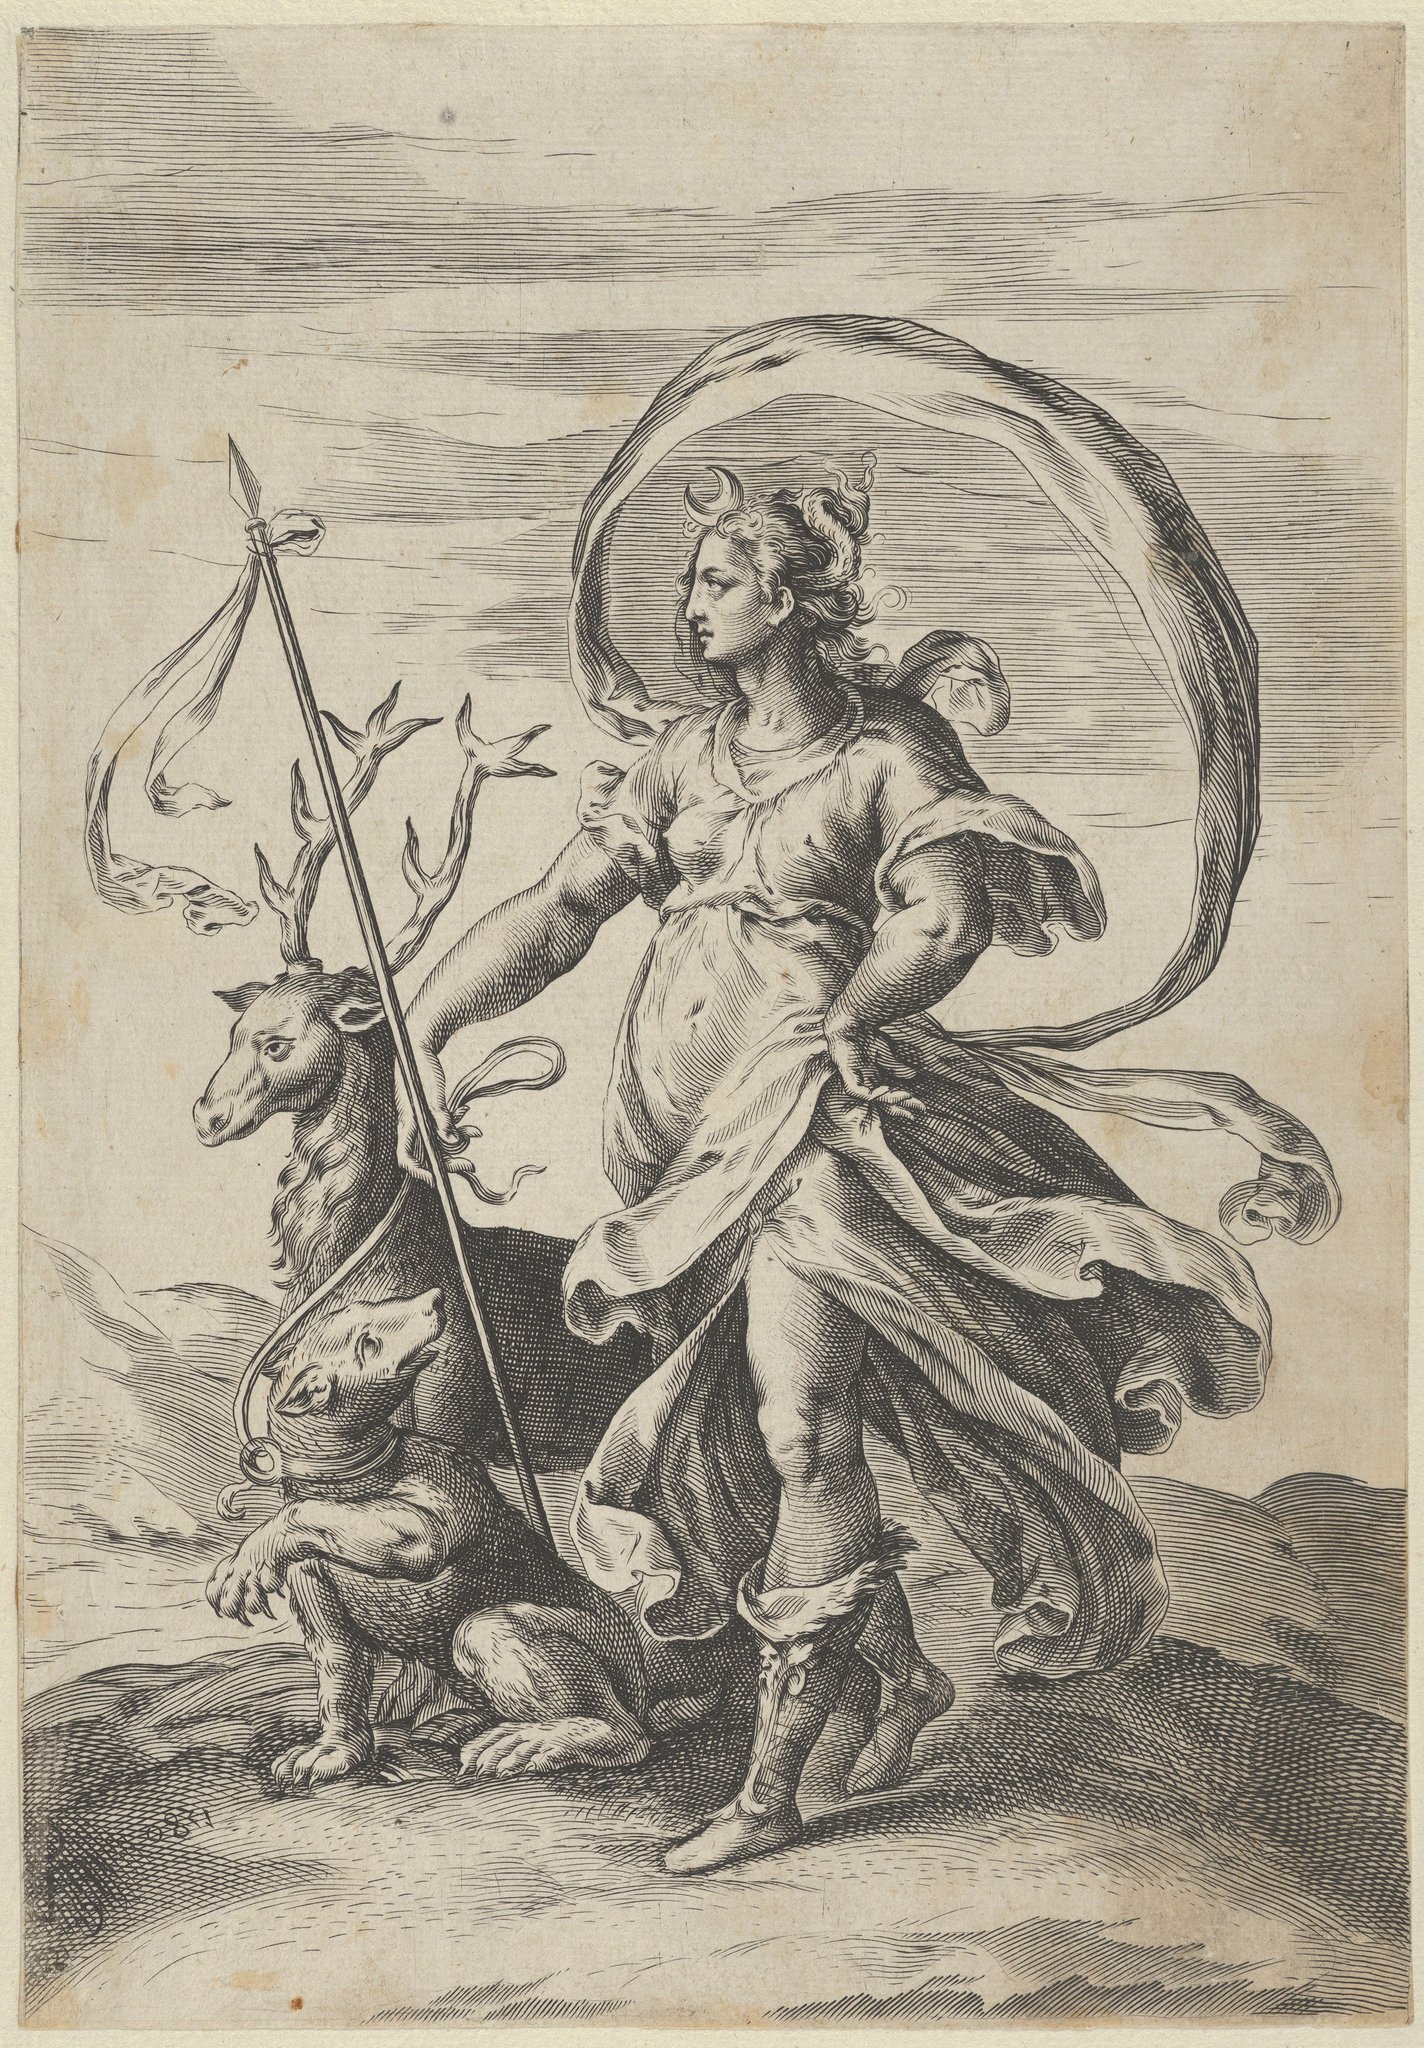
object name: print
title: Diana holding a spear with a stag at right and holding a bear on a leash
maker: cherubino alberti (zaccaria mattia)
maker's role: artist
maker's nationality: italian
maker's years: 1553-1615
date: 1580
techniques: engraving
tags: bears,spears,diana,deer